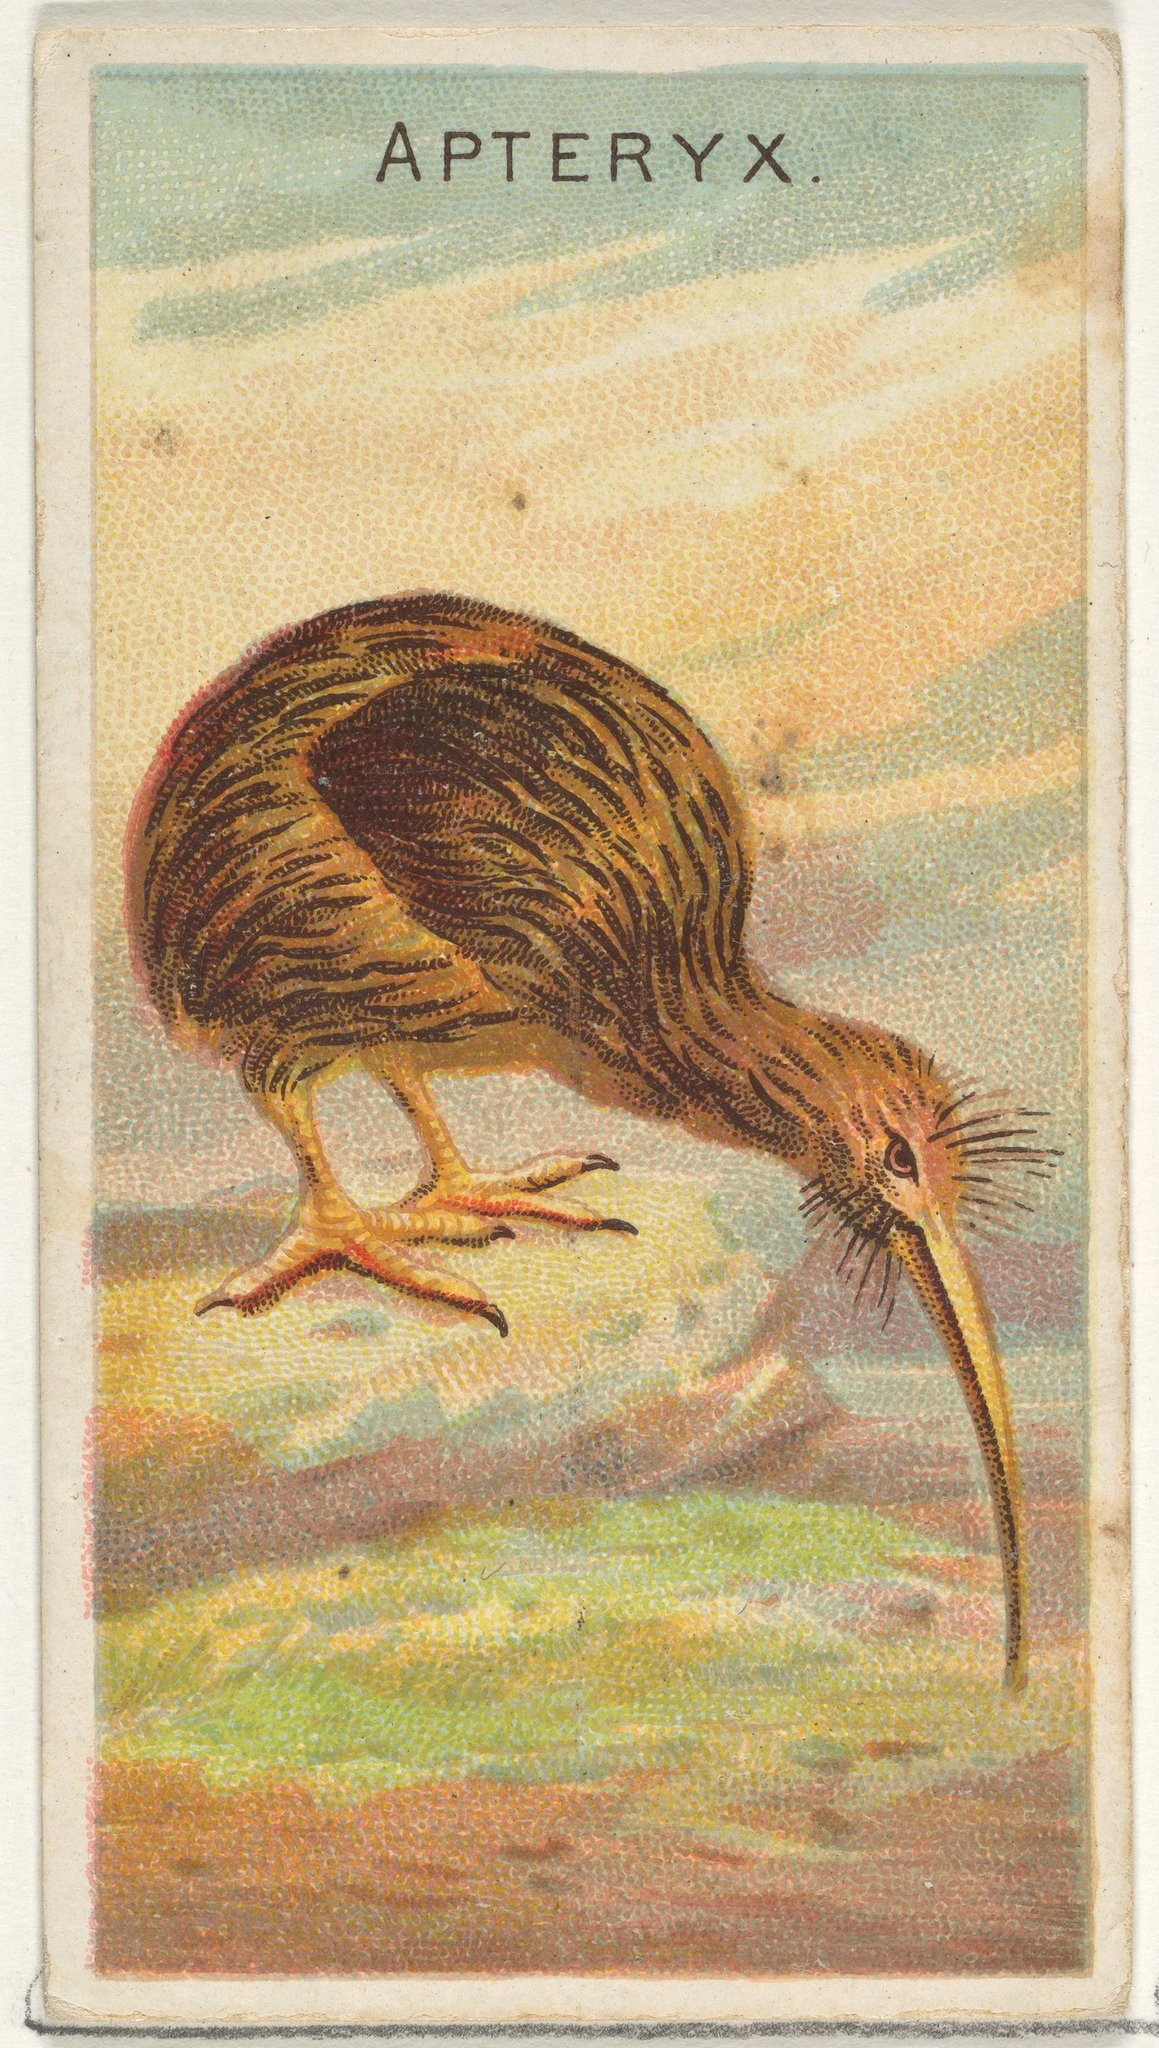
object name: print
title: Apteryx, from the Birds of the Tropics series (N5) for Allen & Ginter Cigarettes Brands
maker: allen & ginter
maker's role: publisher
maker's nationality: american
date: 1889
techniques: color lithograph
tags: birds